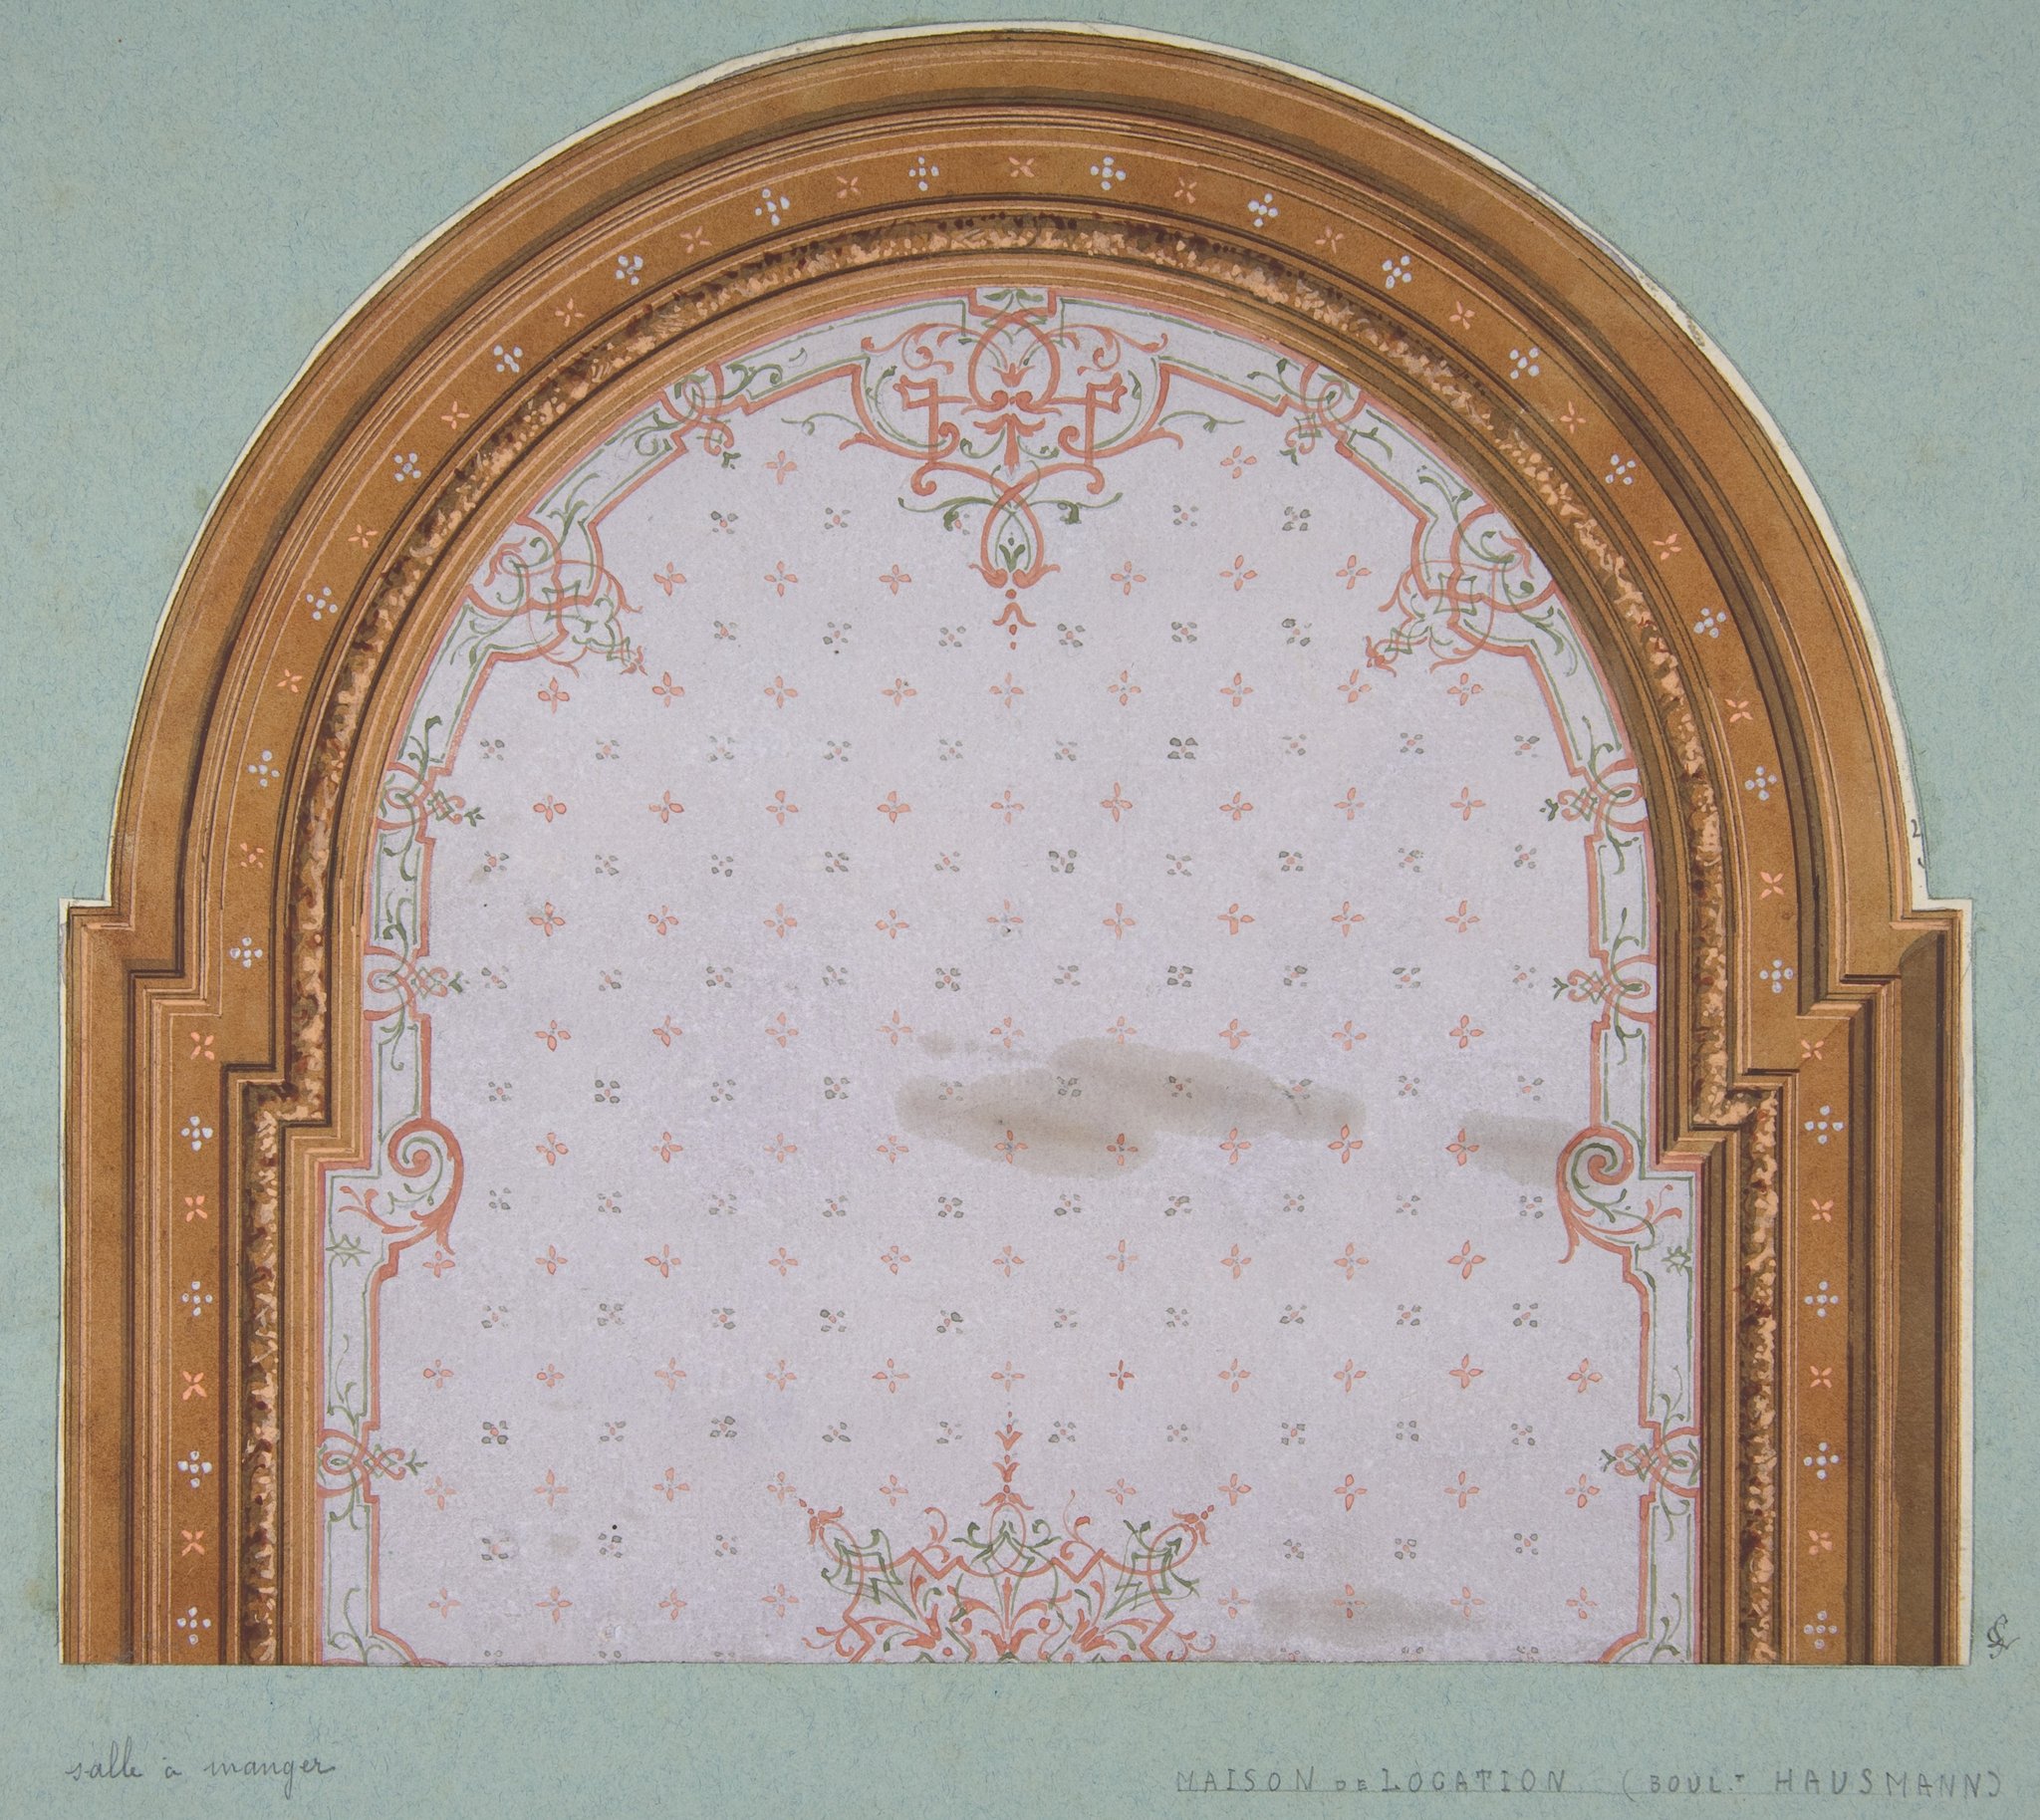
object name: drawing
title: Design for ceiling decoration in a house on the Boulevard Haussmann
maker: jules-edmond-charles lachaise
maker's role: artist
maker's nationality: french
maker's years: 1897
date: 1851-1900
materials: ink, watercolor, paper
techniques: pen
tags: ceilings